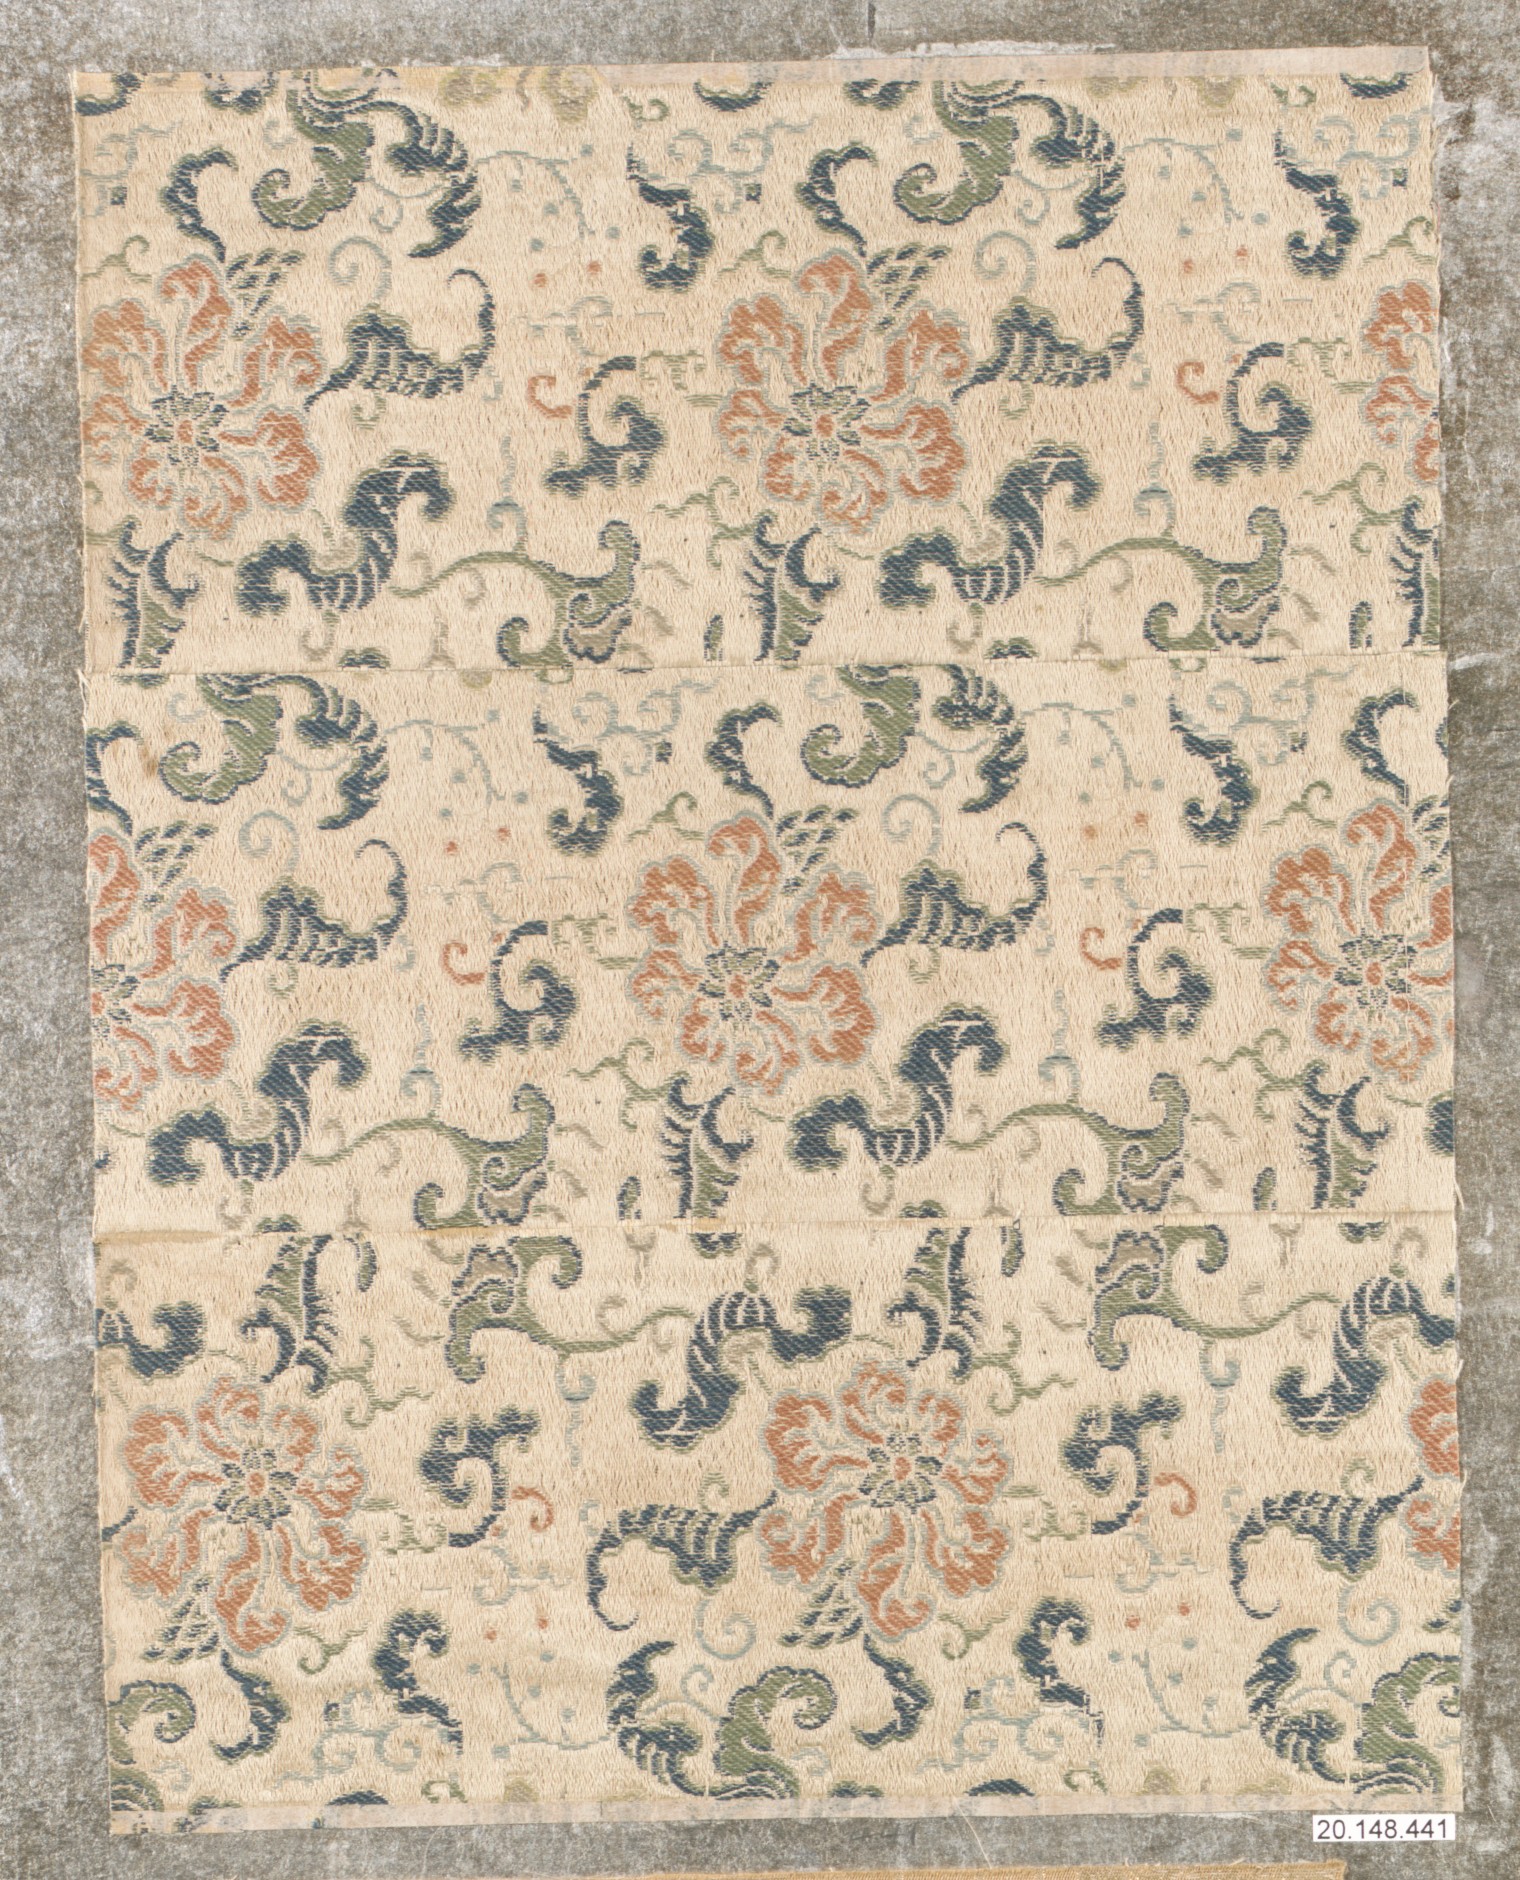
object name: piece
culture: japanese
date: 1601-1700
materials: silk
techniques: compound weave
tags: flowers